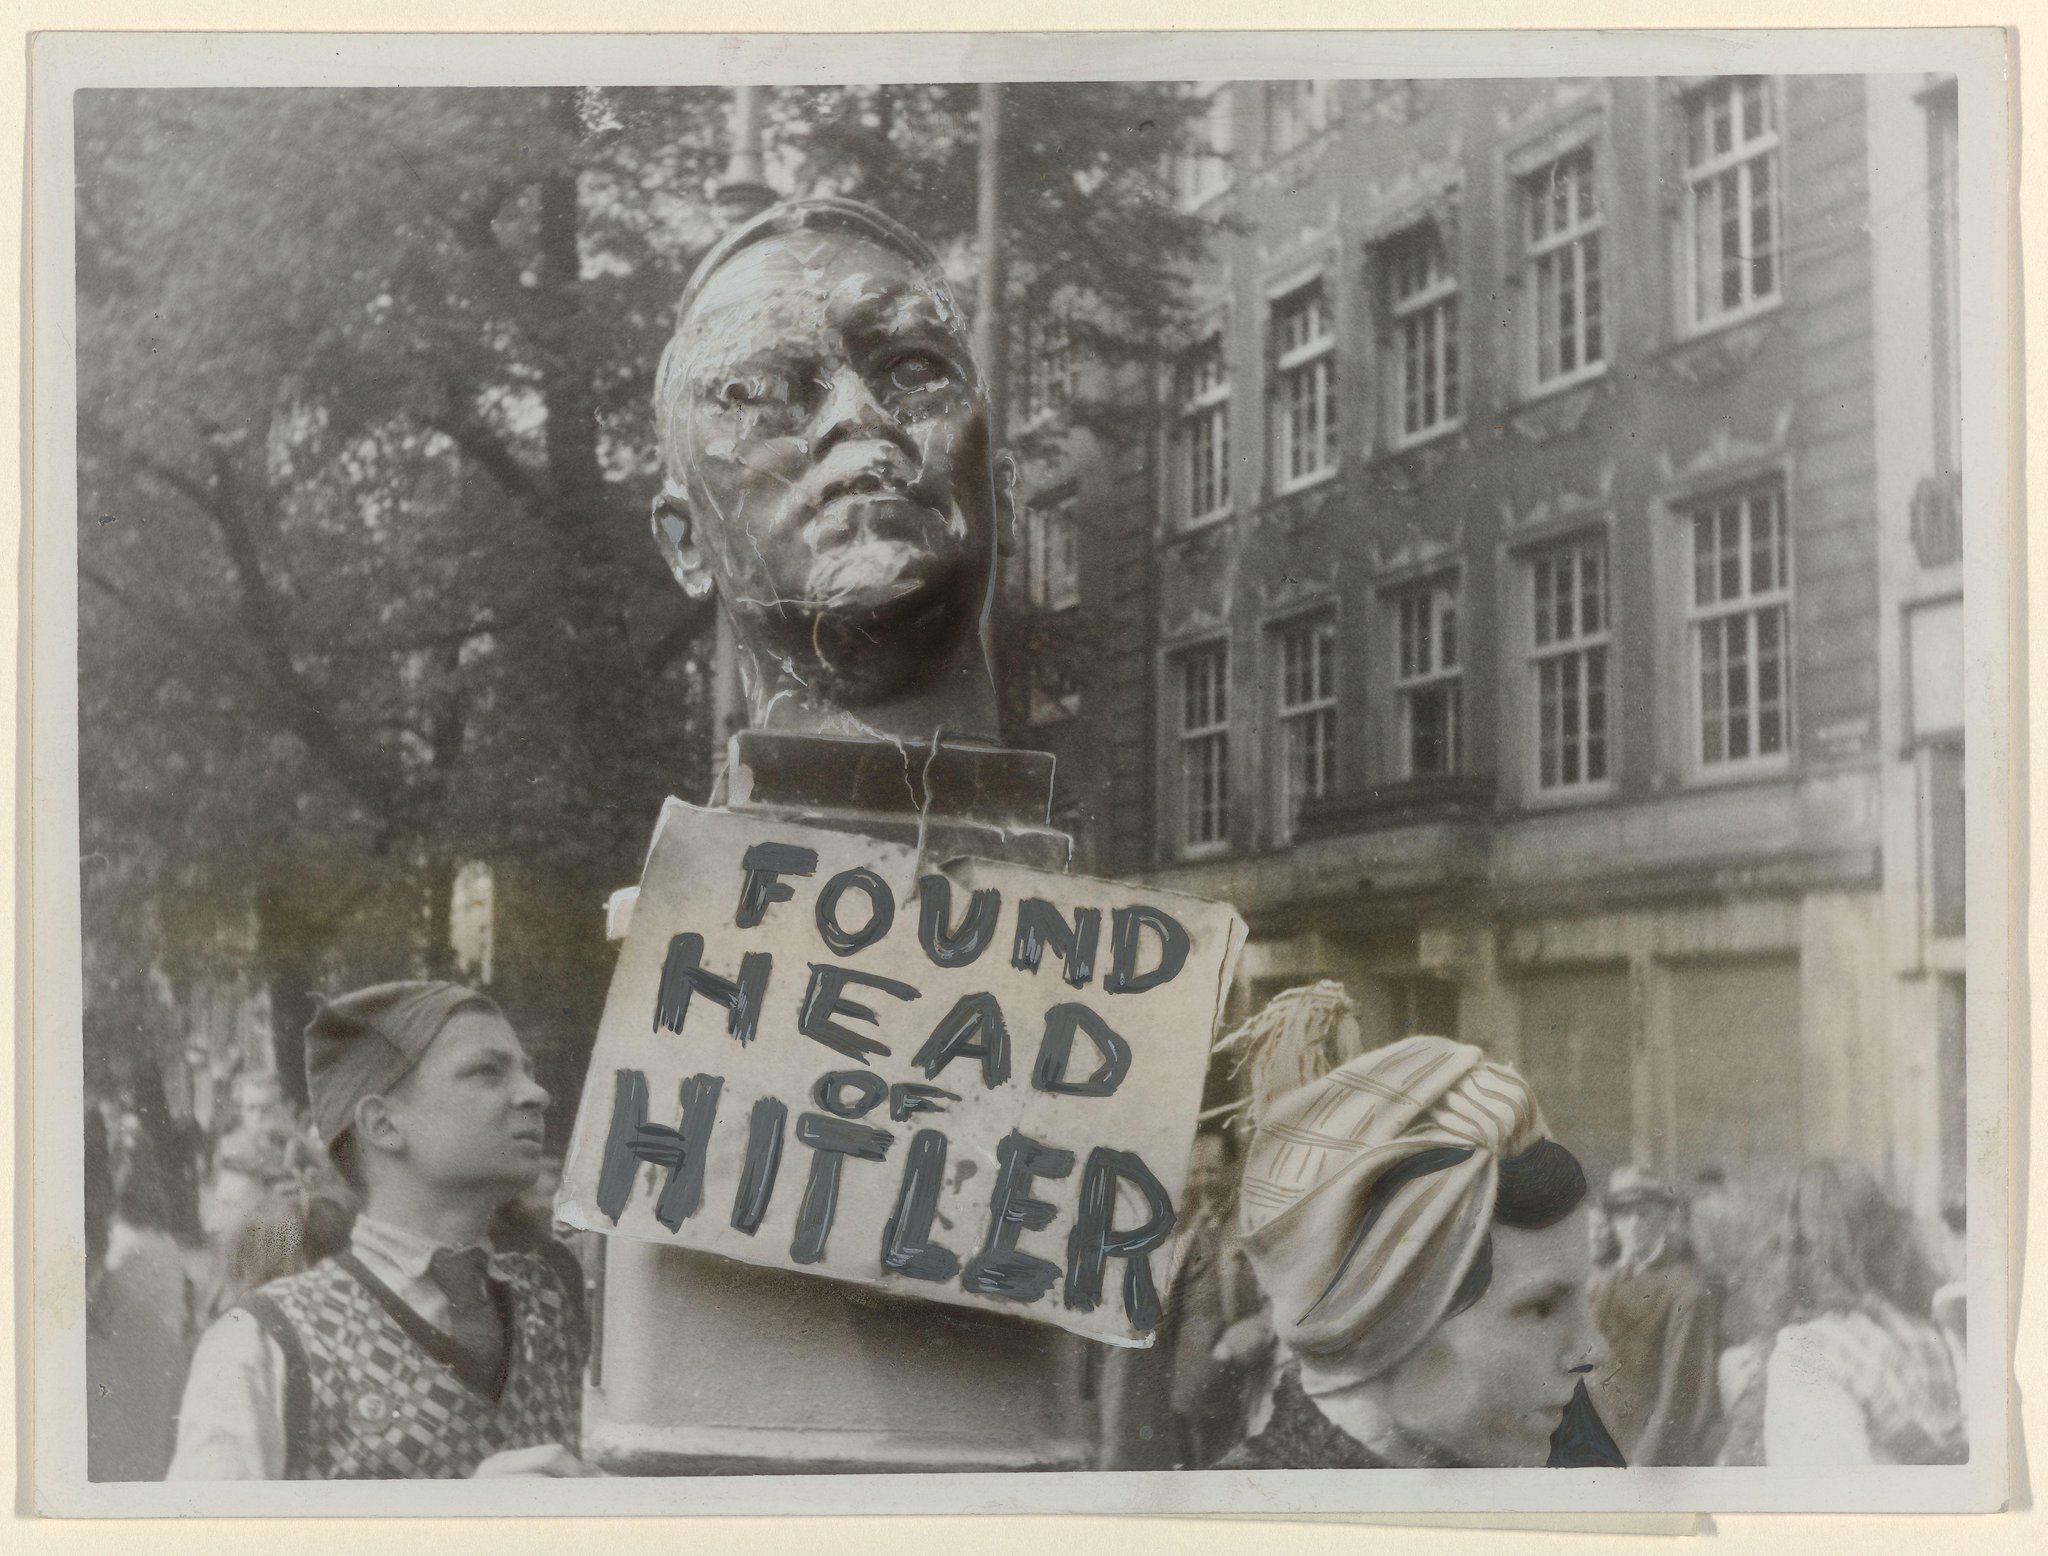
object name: documentary photograph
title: Gehavende kop van Hitler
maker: Anonymous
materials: photographic support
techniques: photography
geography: amsterdam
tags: politician, adolf hitler, publisher, amsterdam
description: Deze foto bevindt zich ook in de collectie van het Verzetsmuseum net als een soortgelijk, maar niet identiek beeld. De fotograaf Ad Windig maakte op precies dezelfde plek een soortgelijke foto met dit verschil: een Nederlands tekstbordje met daarop de tekst : 'Gevonden hoofd van Hitler'. De kop van Hitler staat op een 2.00 meter hoge sokkel en lijkt moeilijk verplaatsbaar. Wellicht foutief bijschrift OVN. De redactie heeft de foto overigens bij laten werken met verf. De kop is iets gehavender gemaakt en het tekstbordje (in het engels) is met zwarte verf ingetekend.